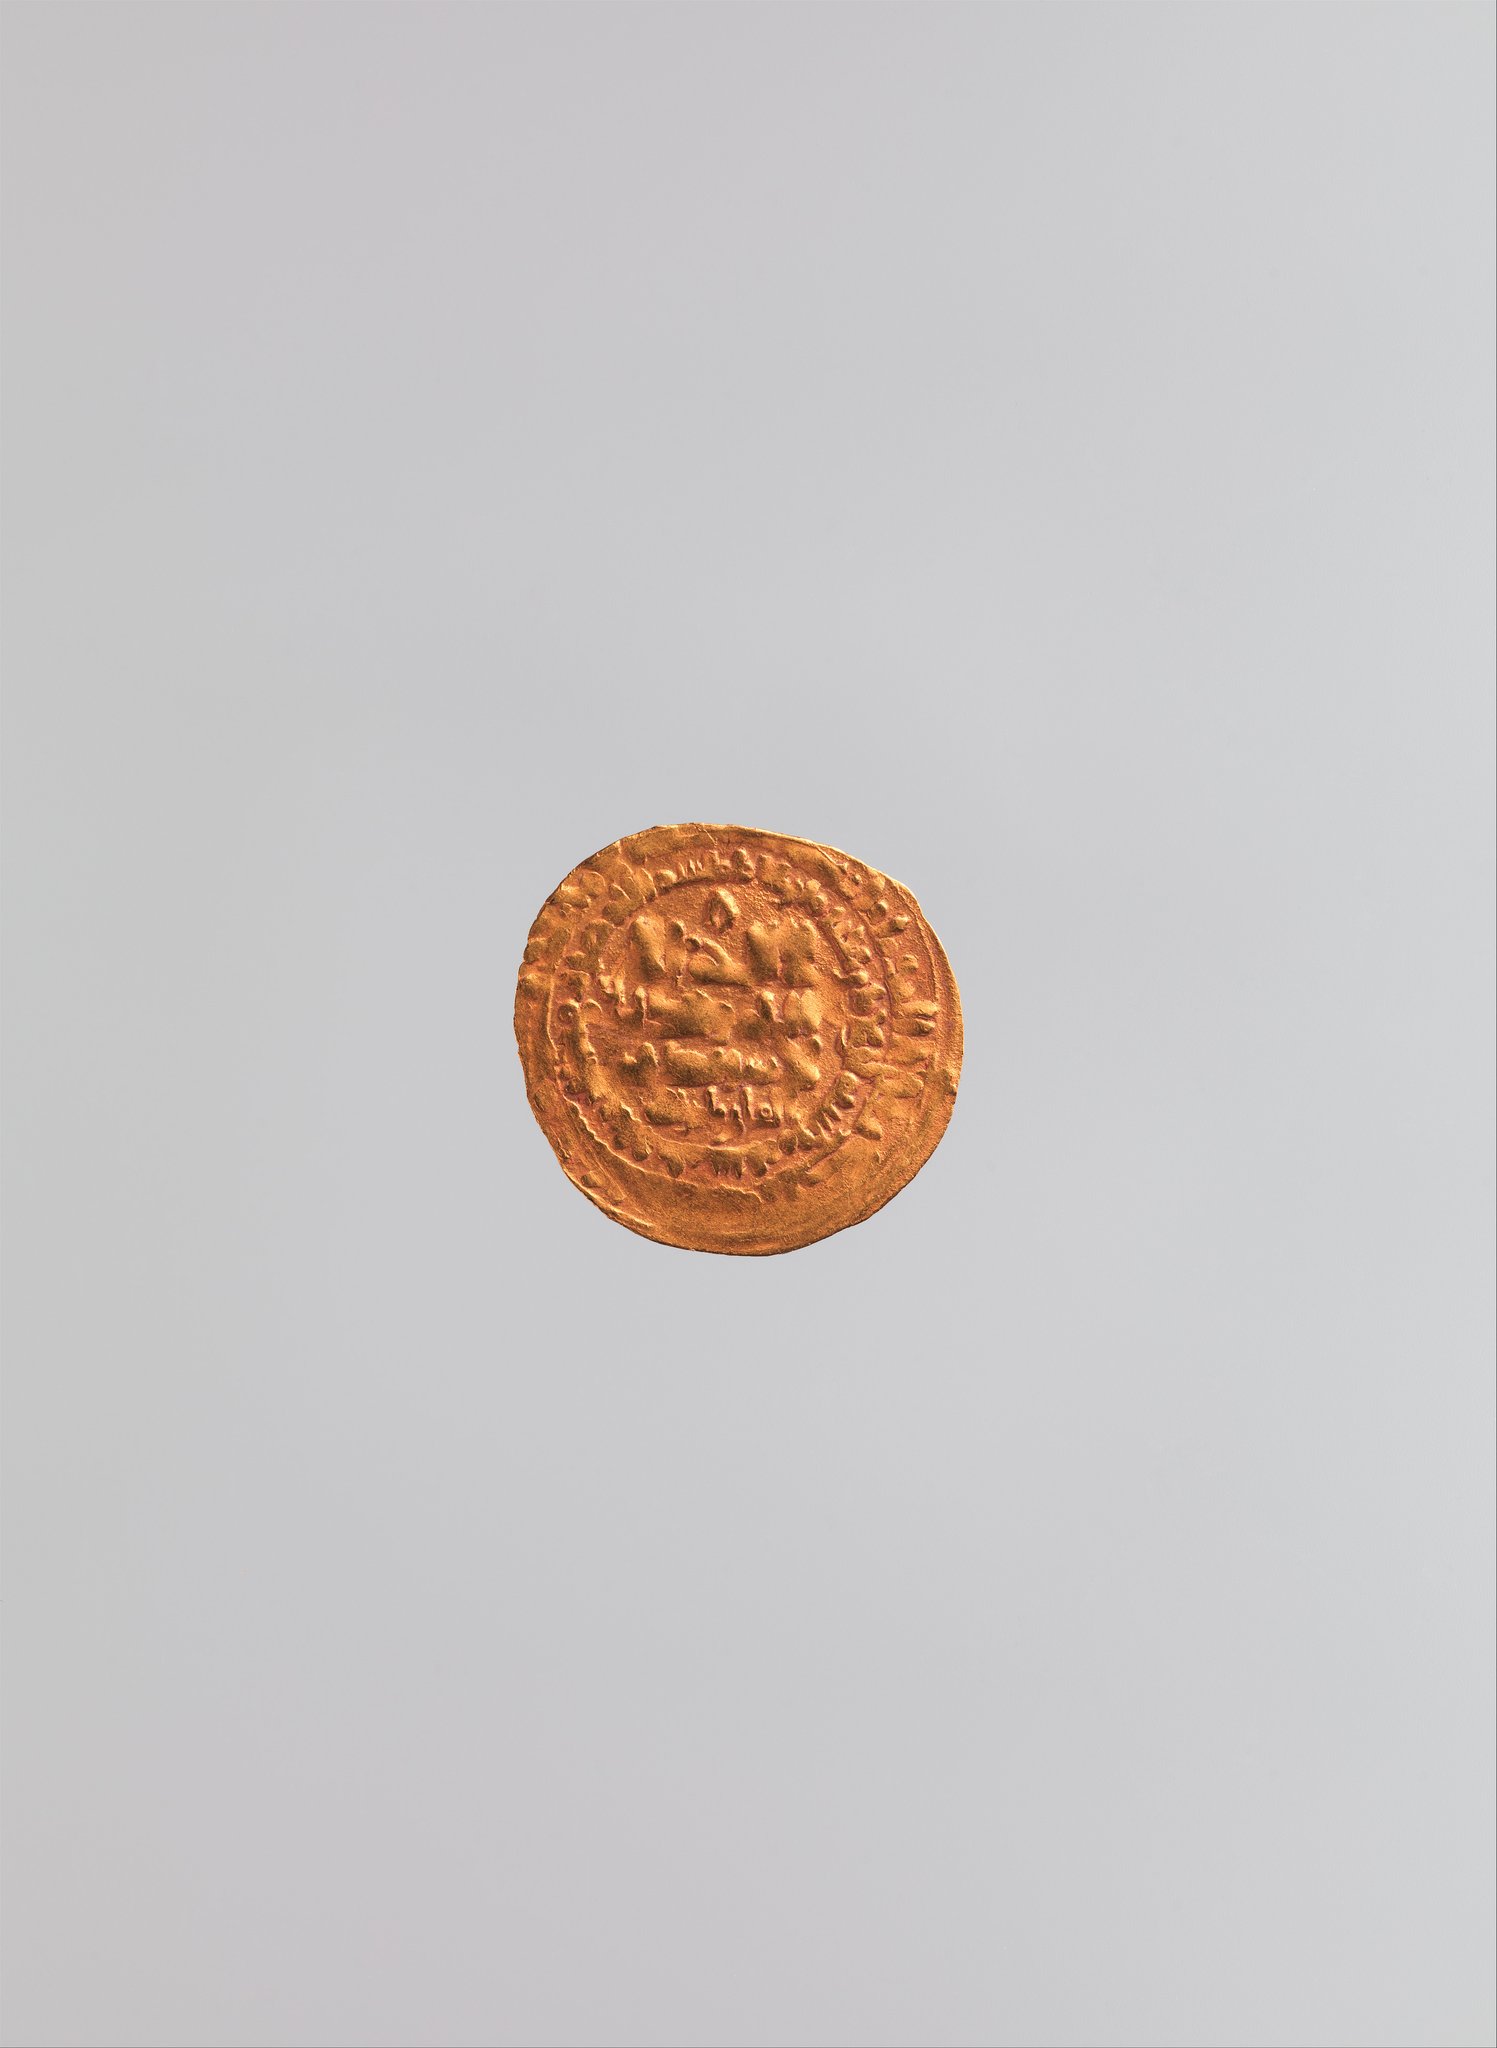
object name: coin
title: Dinar of Tughril (r. 1040–63)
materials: gold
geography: iran